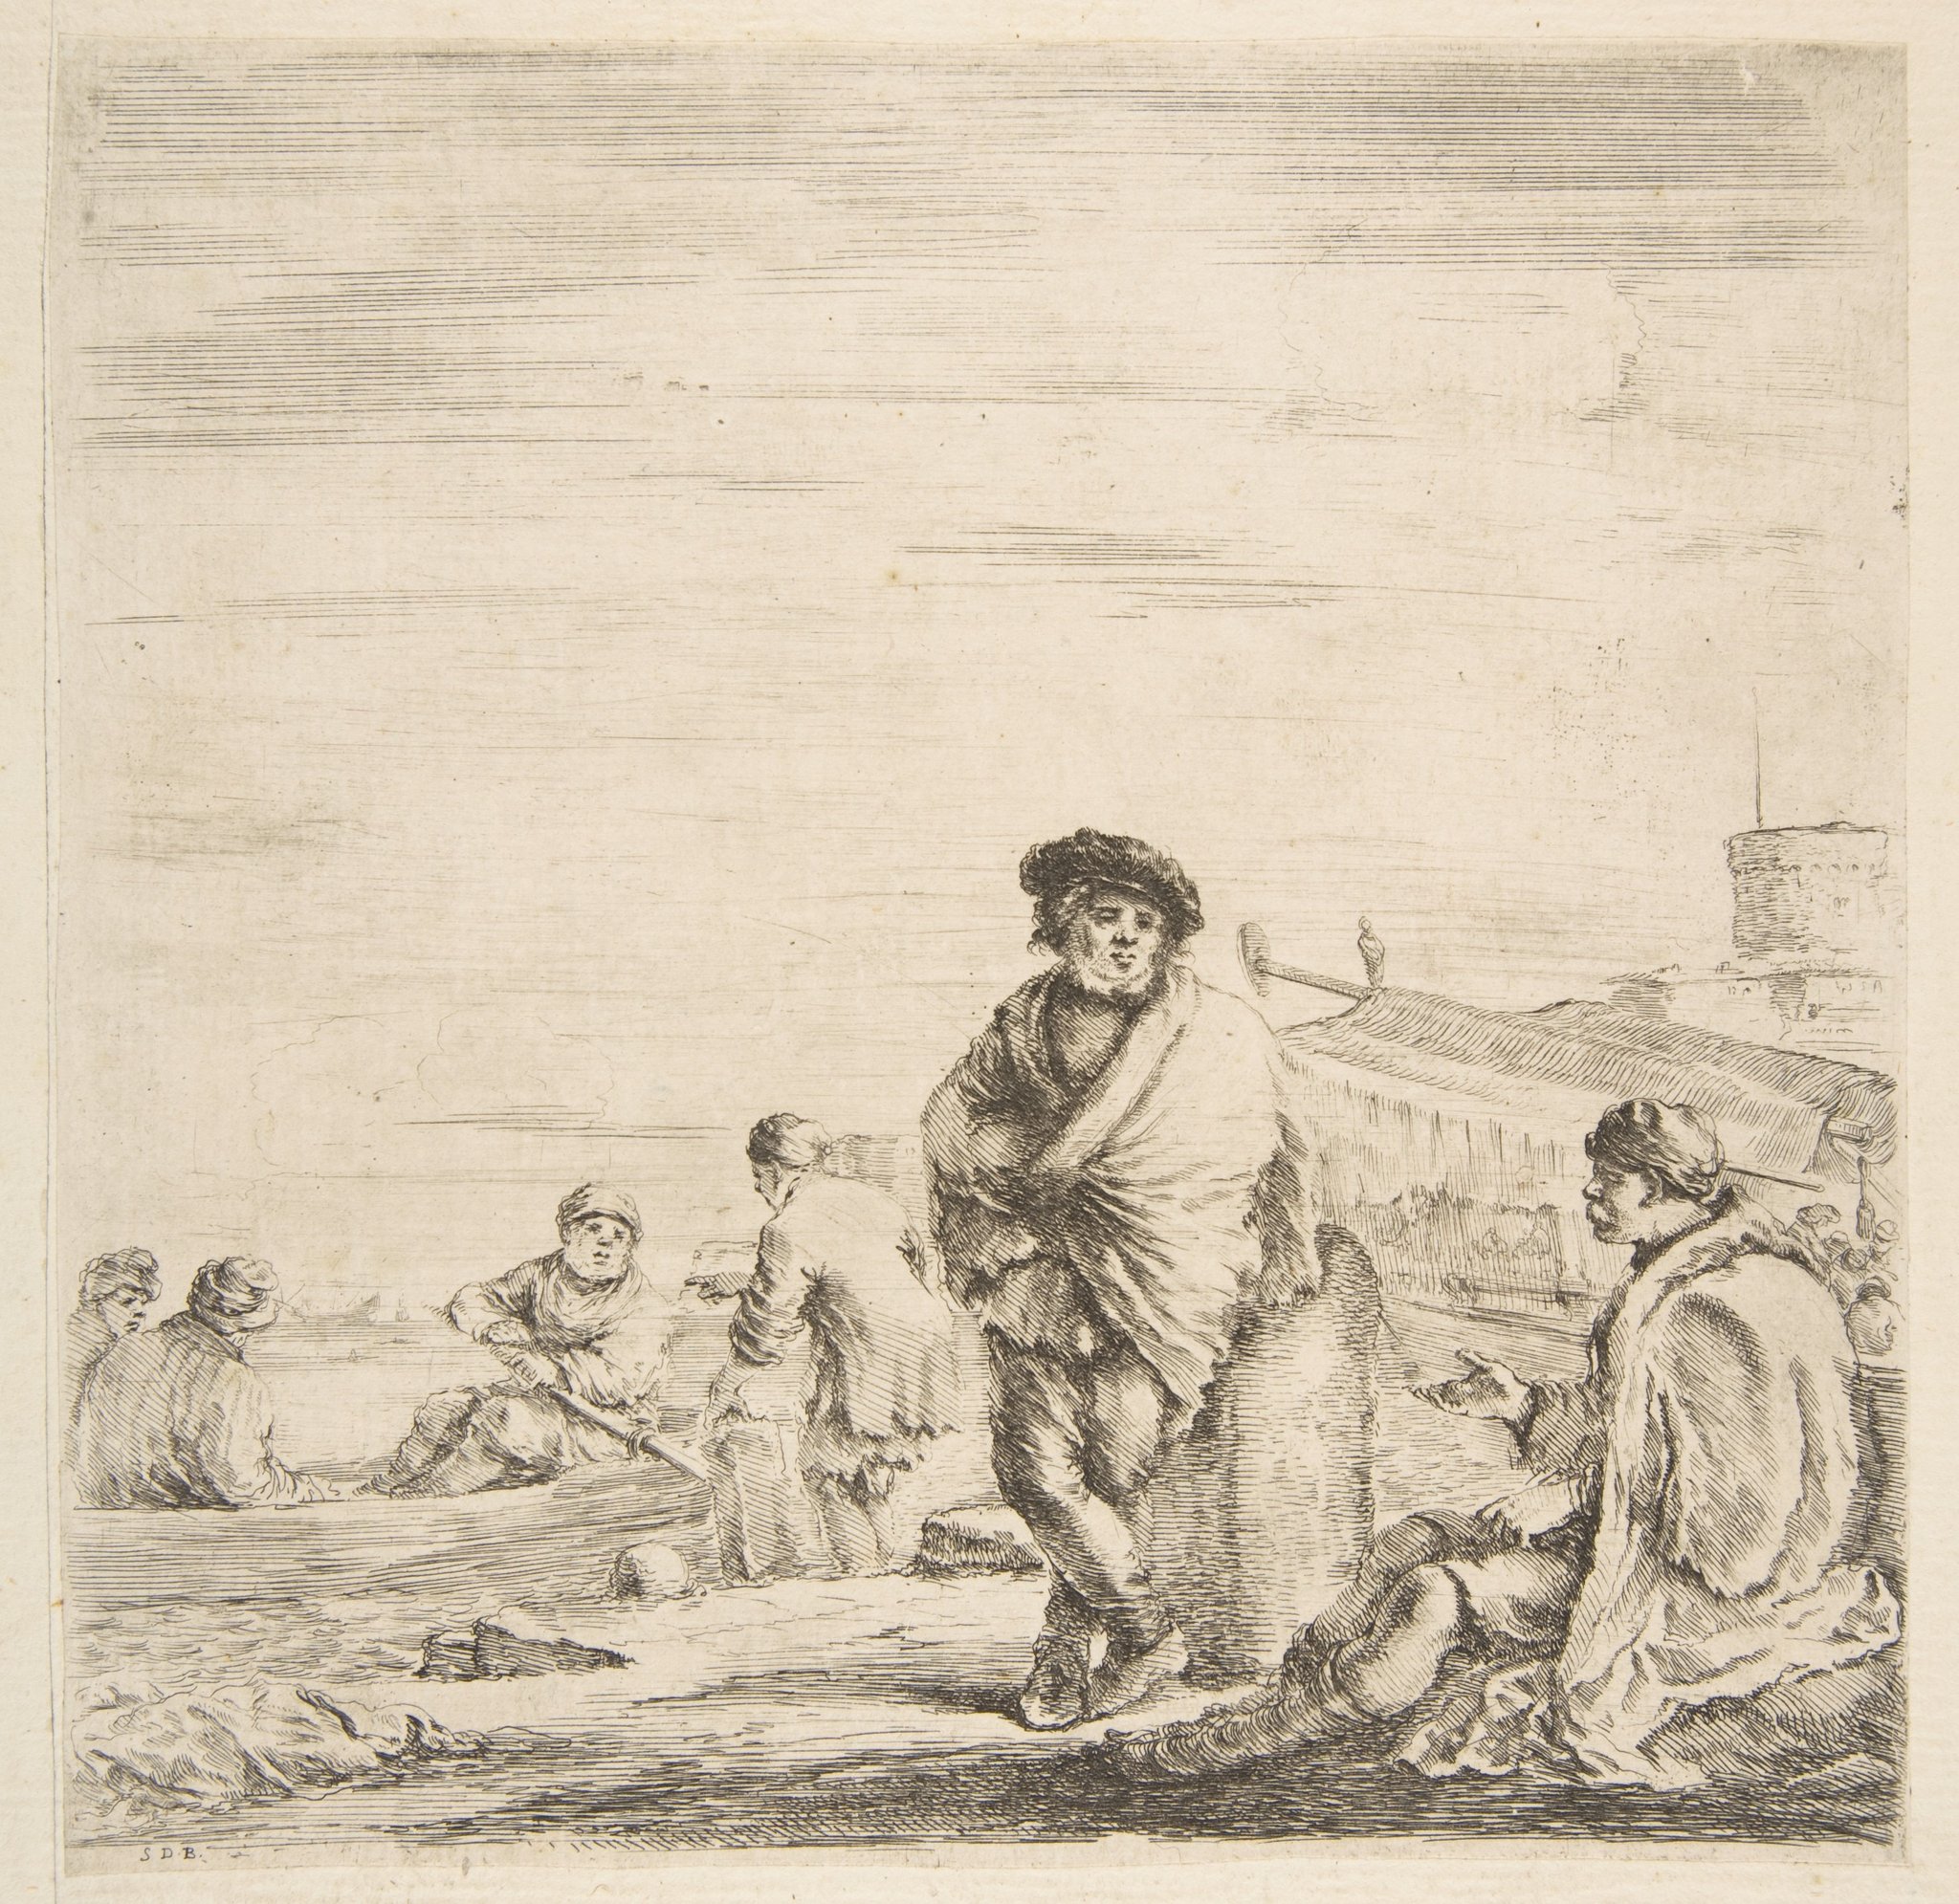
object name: print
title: A standing sailor talking to a seated Levantine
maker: stefano della bella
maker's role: artist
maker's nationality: italian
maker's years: 1610-1664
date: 1660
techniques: etching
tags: men,sailors,boats